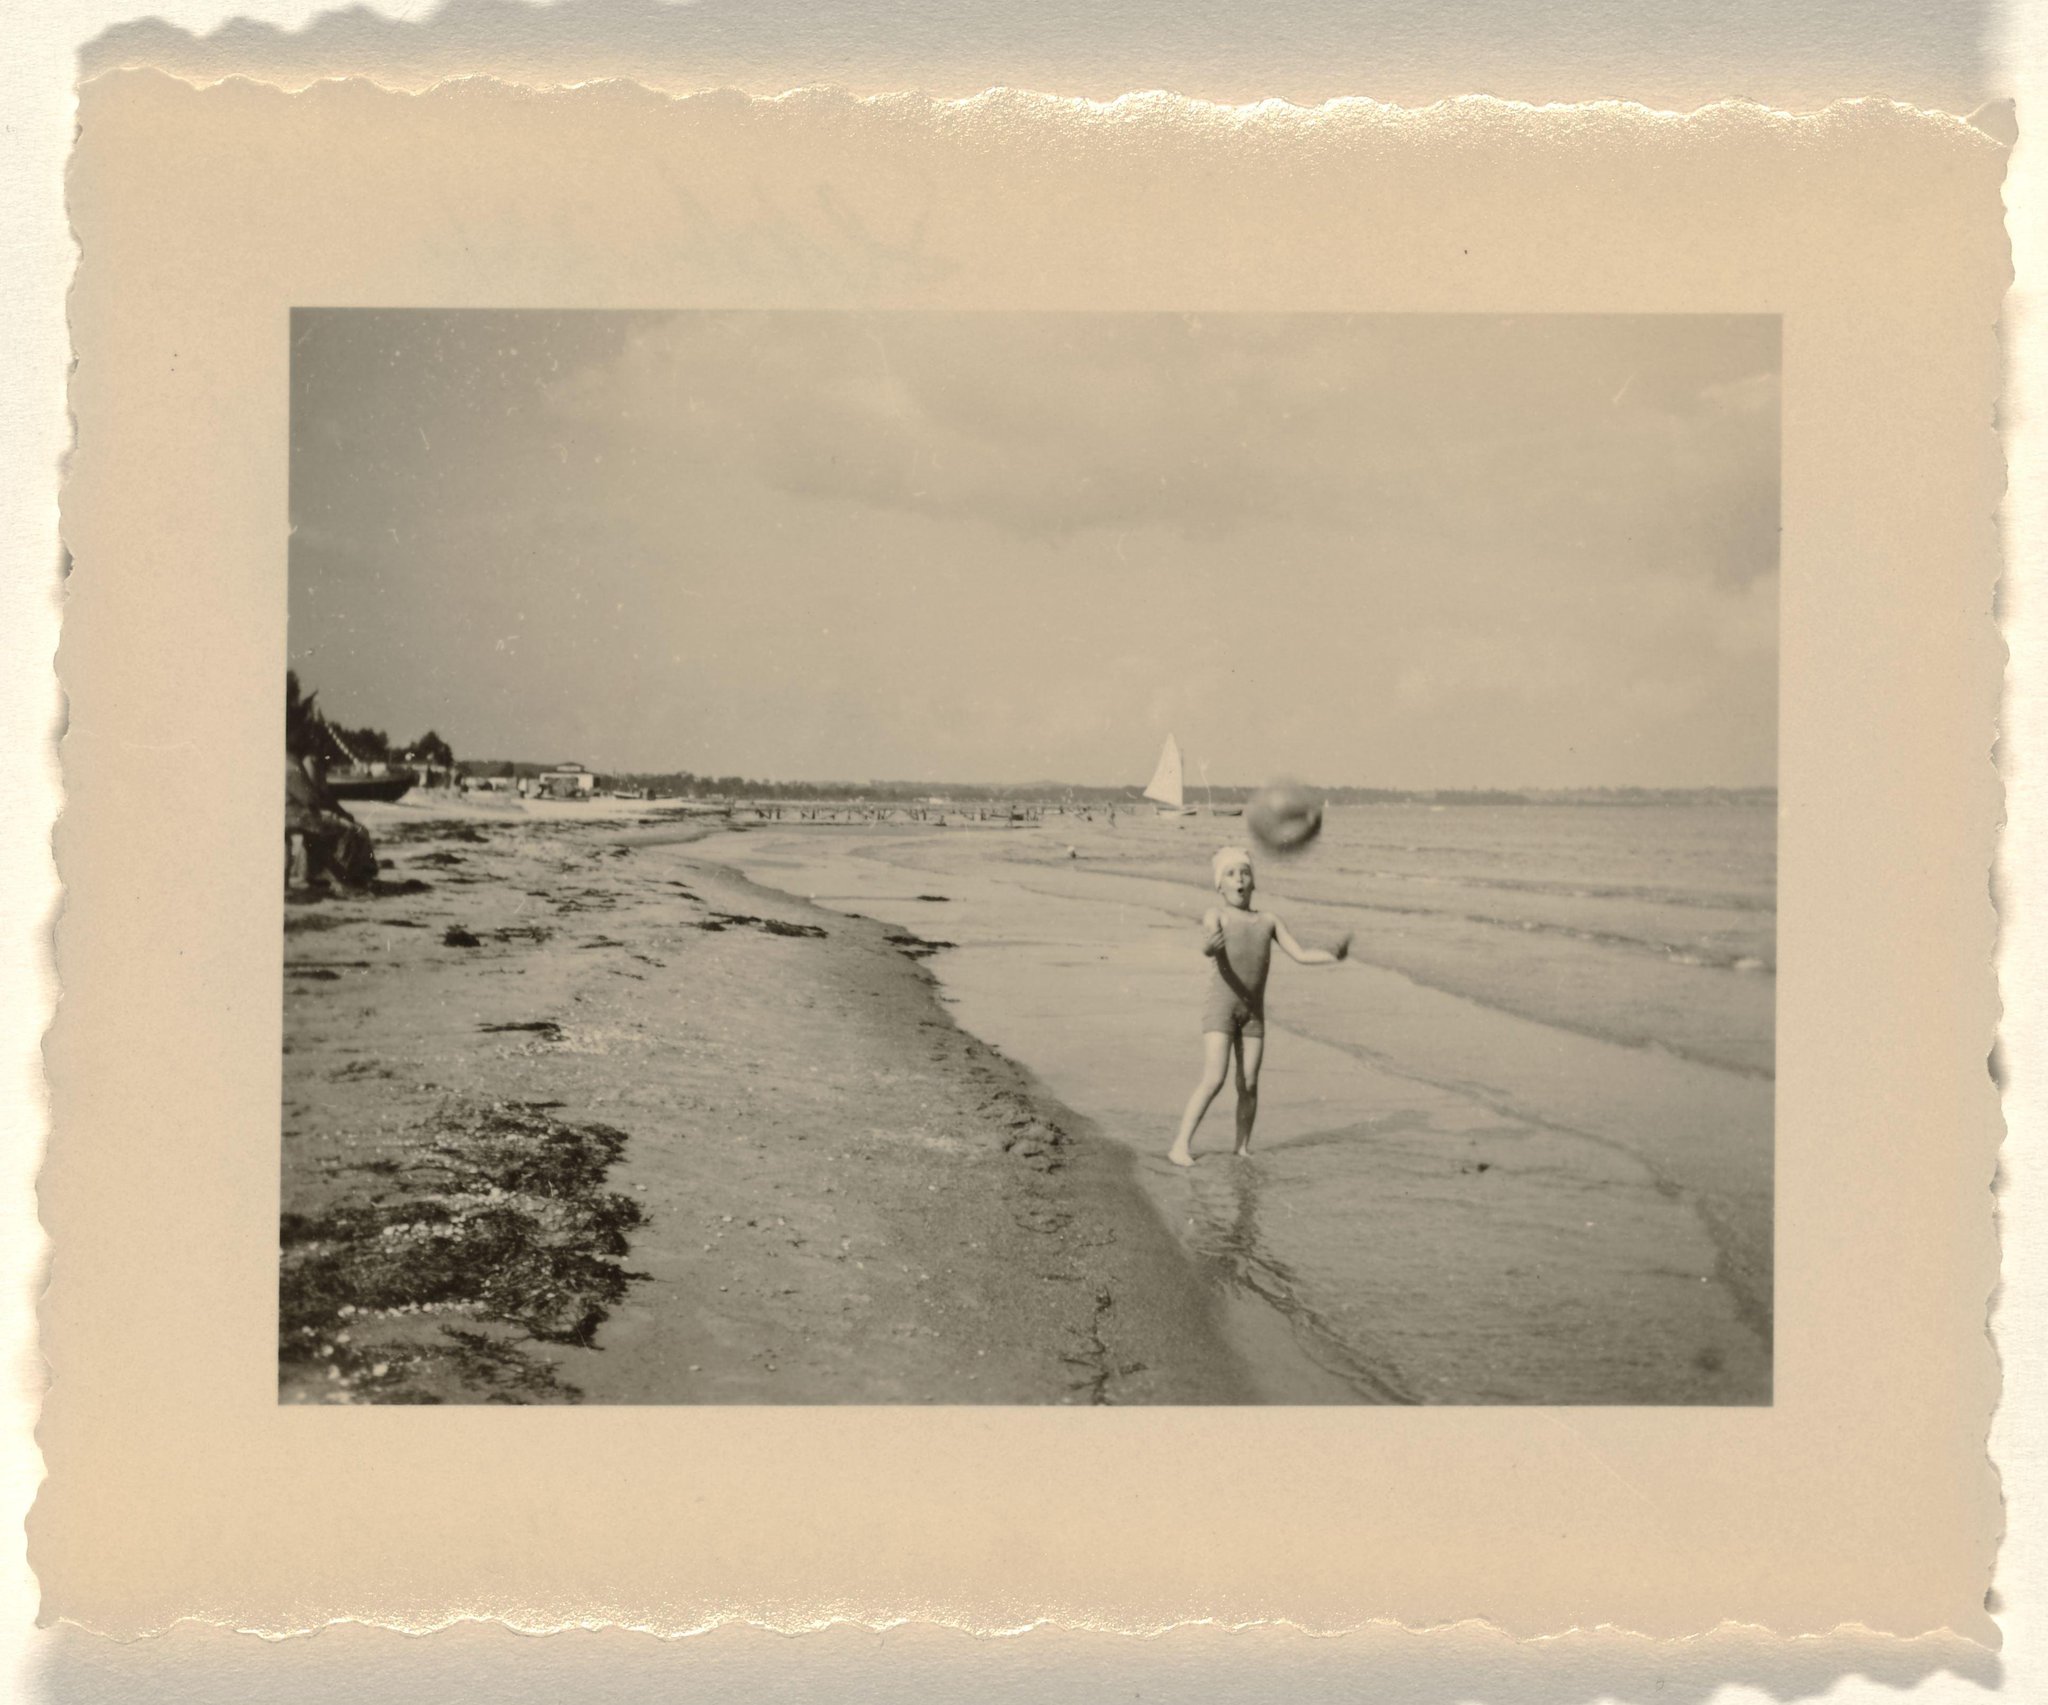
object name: photograph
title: Isabel Wachenheimer op strand van Scharbeutz, september 1934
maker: Anonymous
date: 1909-1934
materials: photographic support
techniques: gelatin silver print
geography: scharbeutz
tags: leiden, isabel wachenheimer-elon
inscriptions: date: ‘Sept.34. Isabel in Scharbeutz 32’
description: Dit object is onderdeel van de nalatenschap van Isabel Elon-Wachenheimer (1928-2010). Tot haar overlijden behoorde het samen met de andere objecten uit de nalatenschap tot haar privédomein van Isabel Wachenheimer. In die particuliere context zijn deze objecten tezamen en individueel aandenkens - aan de jeugd, ouders en familie van Isabel Wachenheimer vóór en tijdens de Shoah en aan haar leven na de Tweede Wereldoorlog. Isabel Wachenheimer, die van juni 1943 tot mei 1945 gevangen zat in Kamp Westerbork, Theresienstadt, Auschwitz, Lenzing a/d Oberdonau (een buitenkamp van Mauthausen), overleefde de Shoah. Haar ouders – Eugène Wachenheimer en Else Wachenheimer-Moos - werden op 14 oktober 1944 in Auschwitz-Birkenau vermoord.